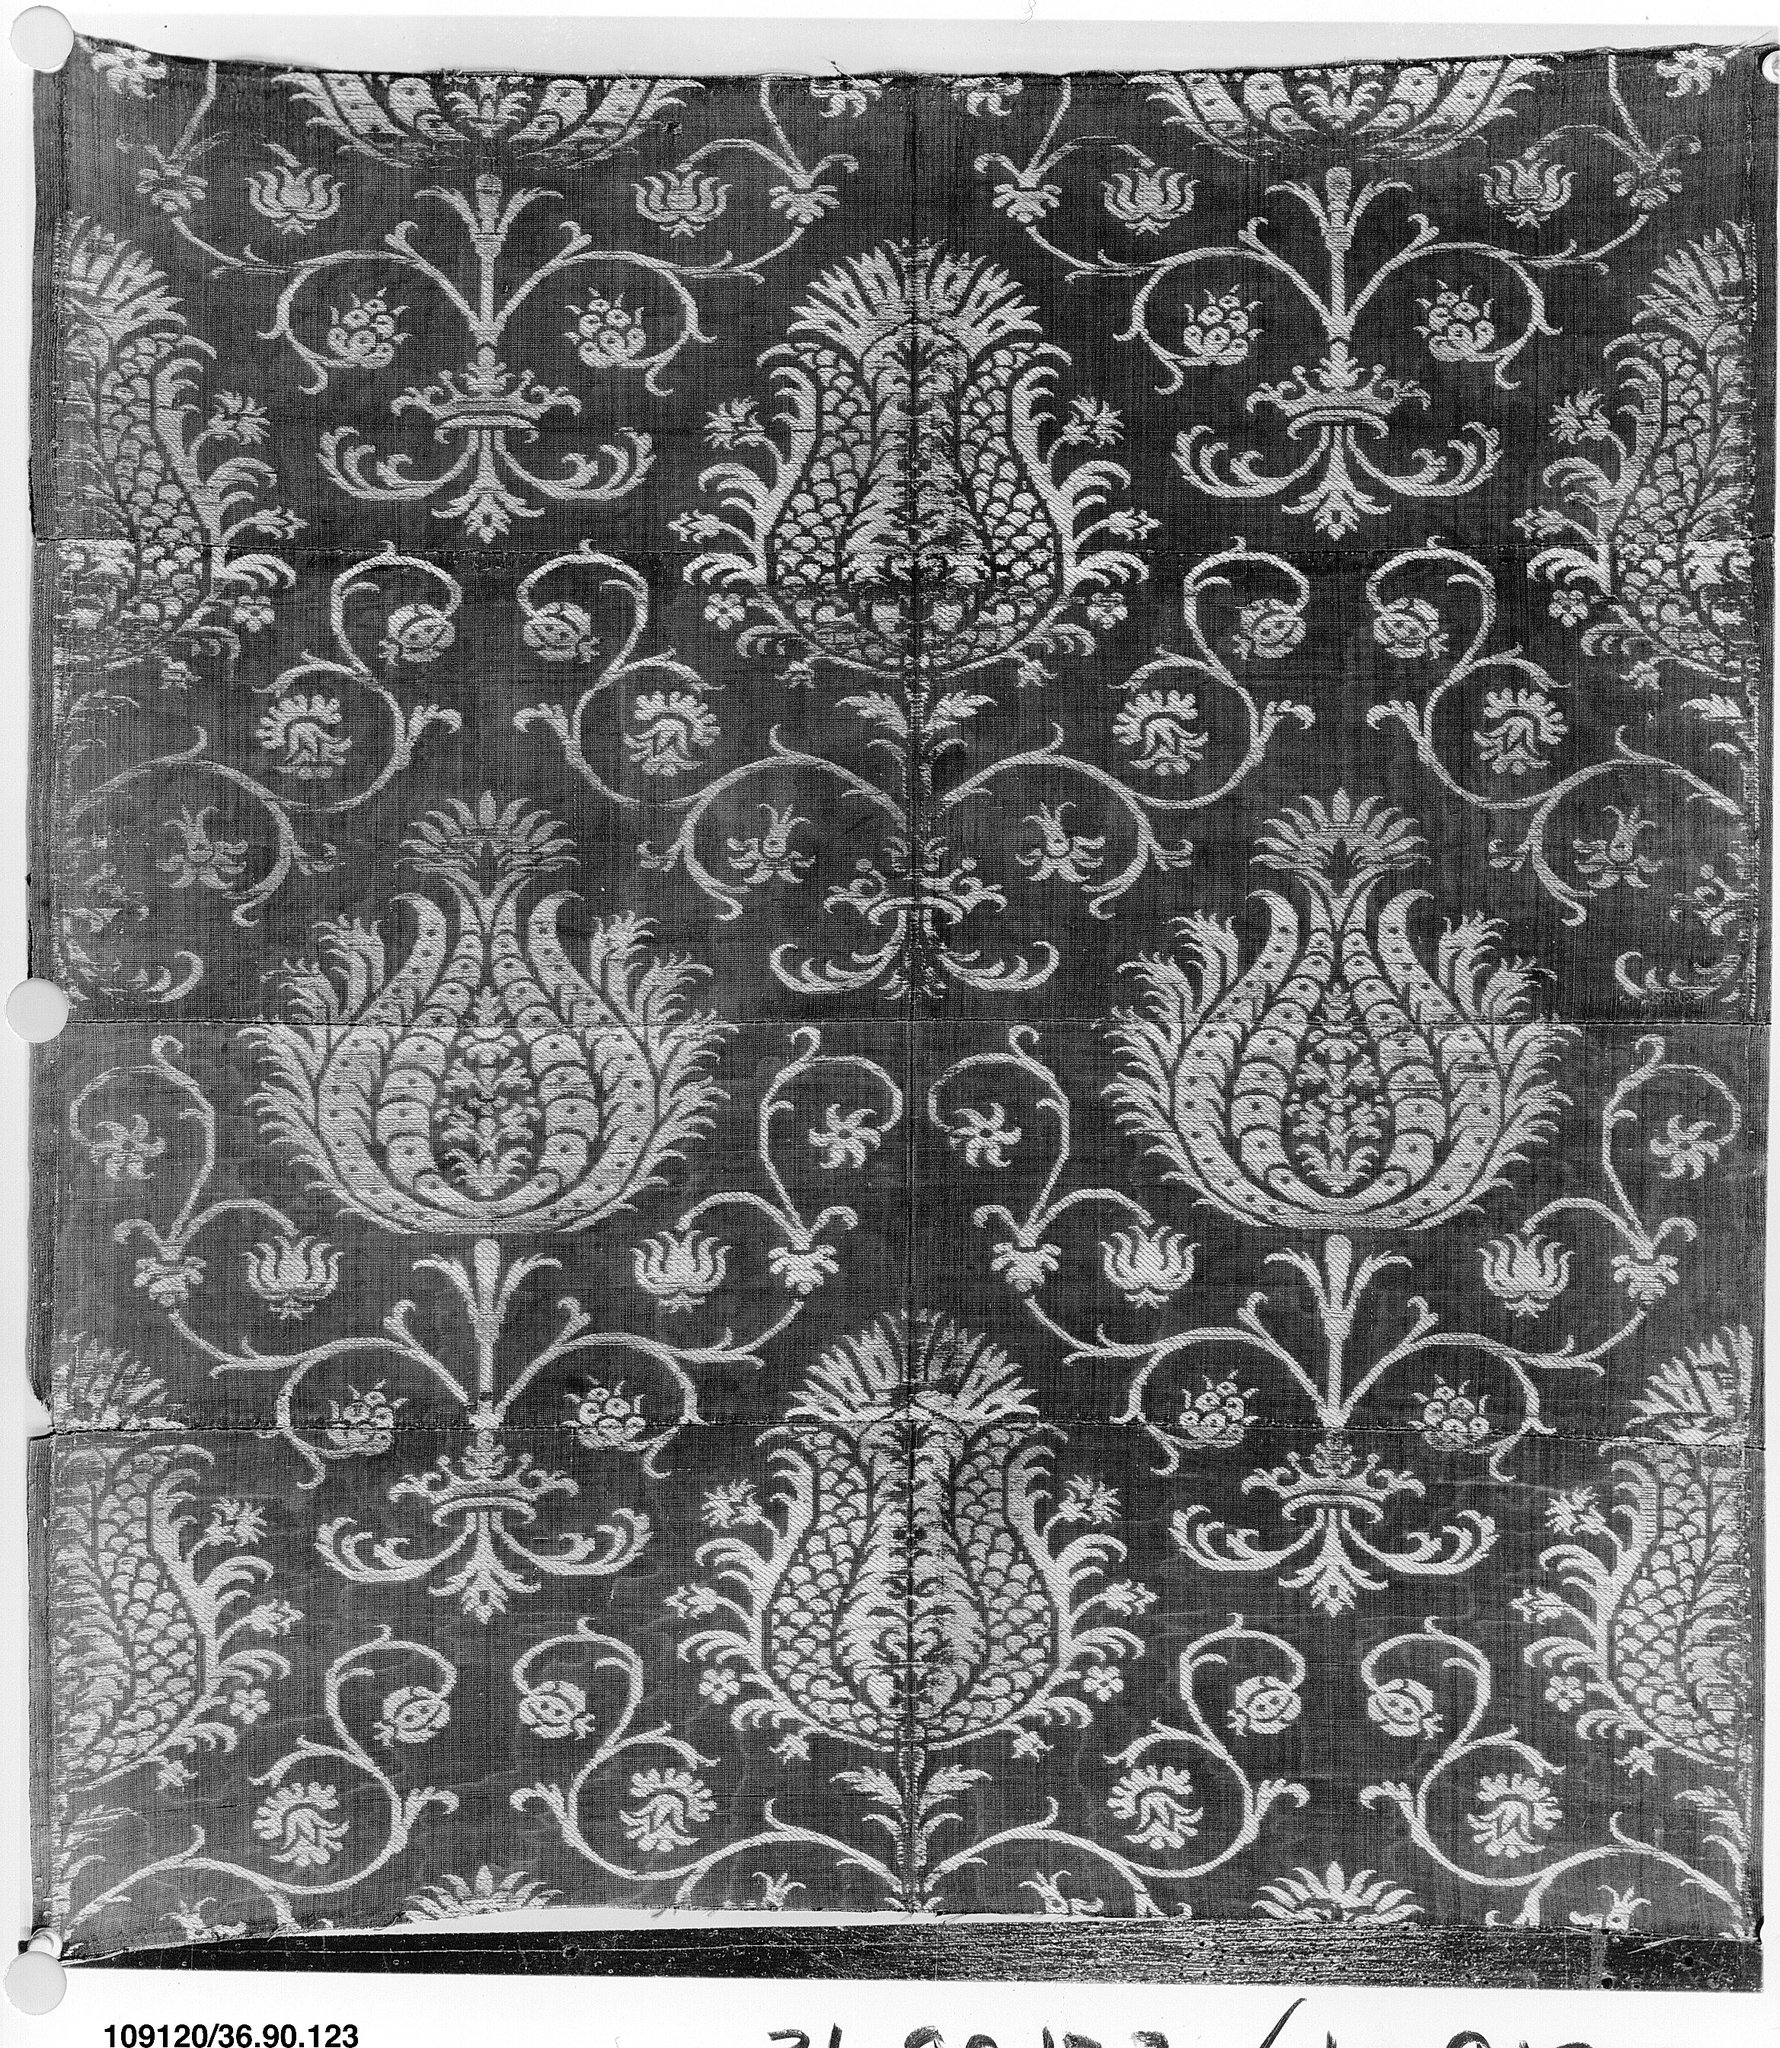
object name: piece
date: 1501-1600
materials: silk